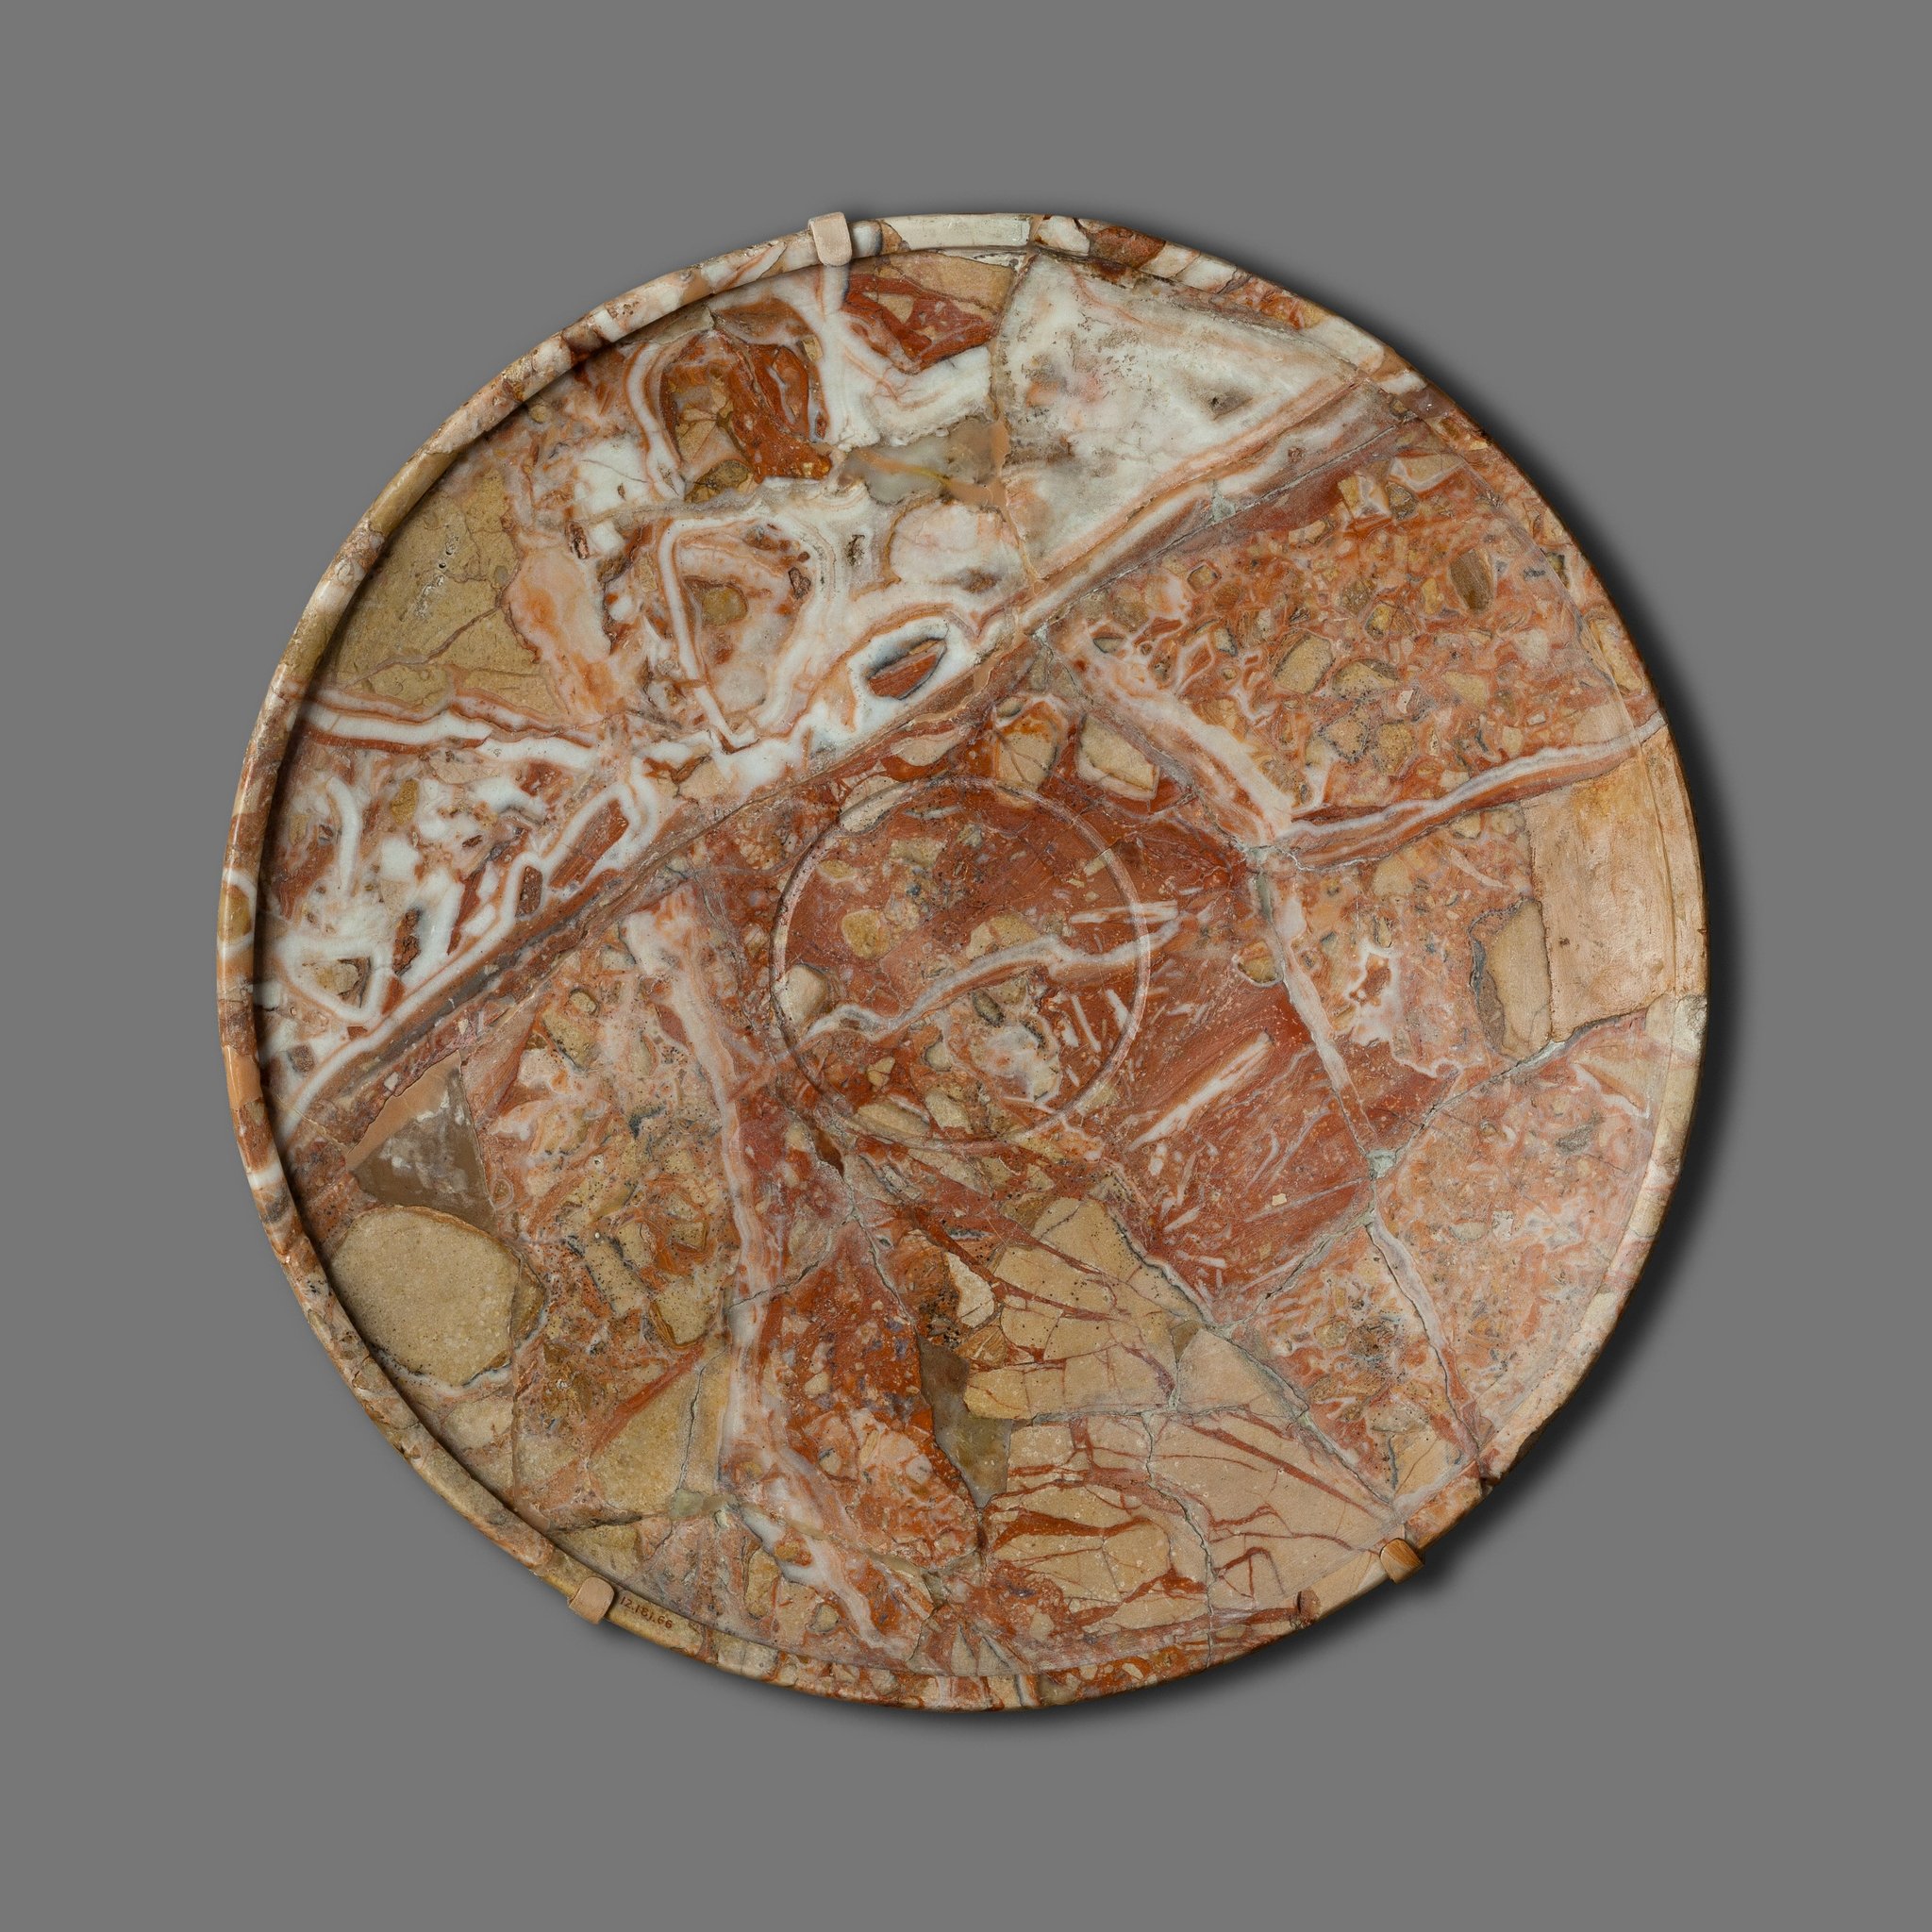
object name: dish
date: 2750-2649 BCE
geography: egypt